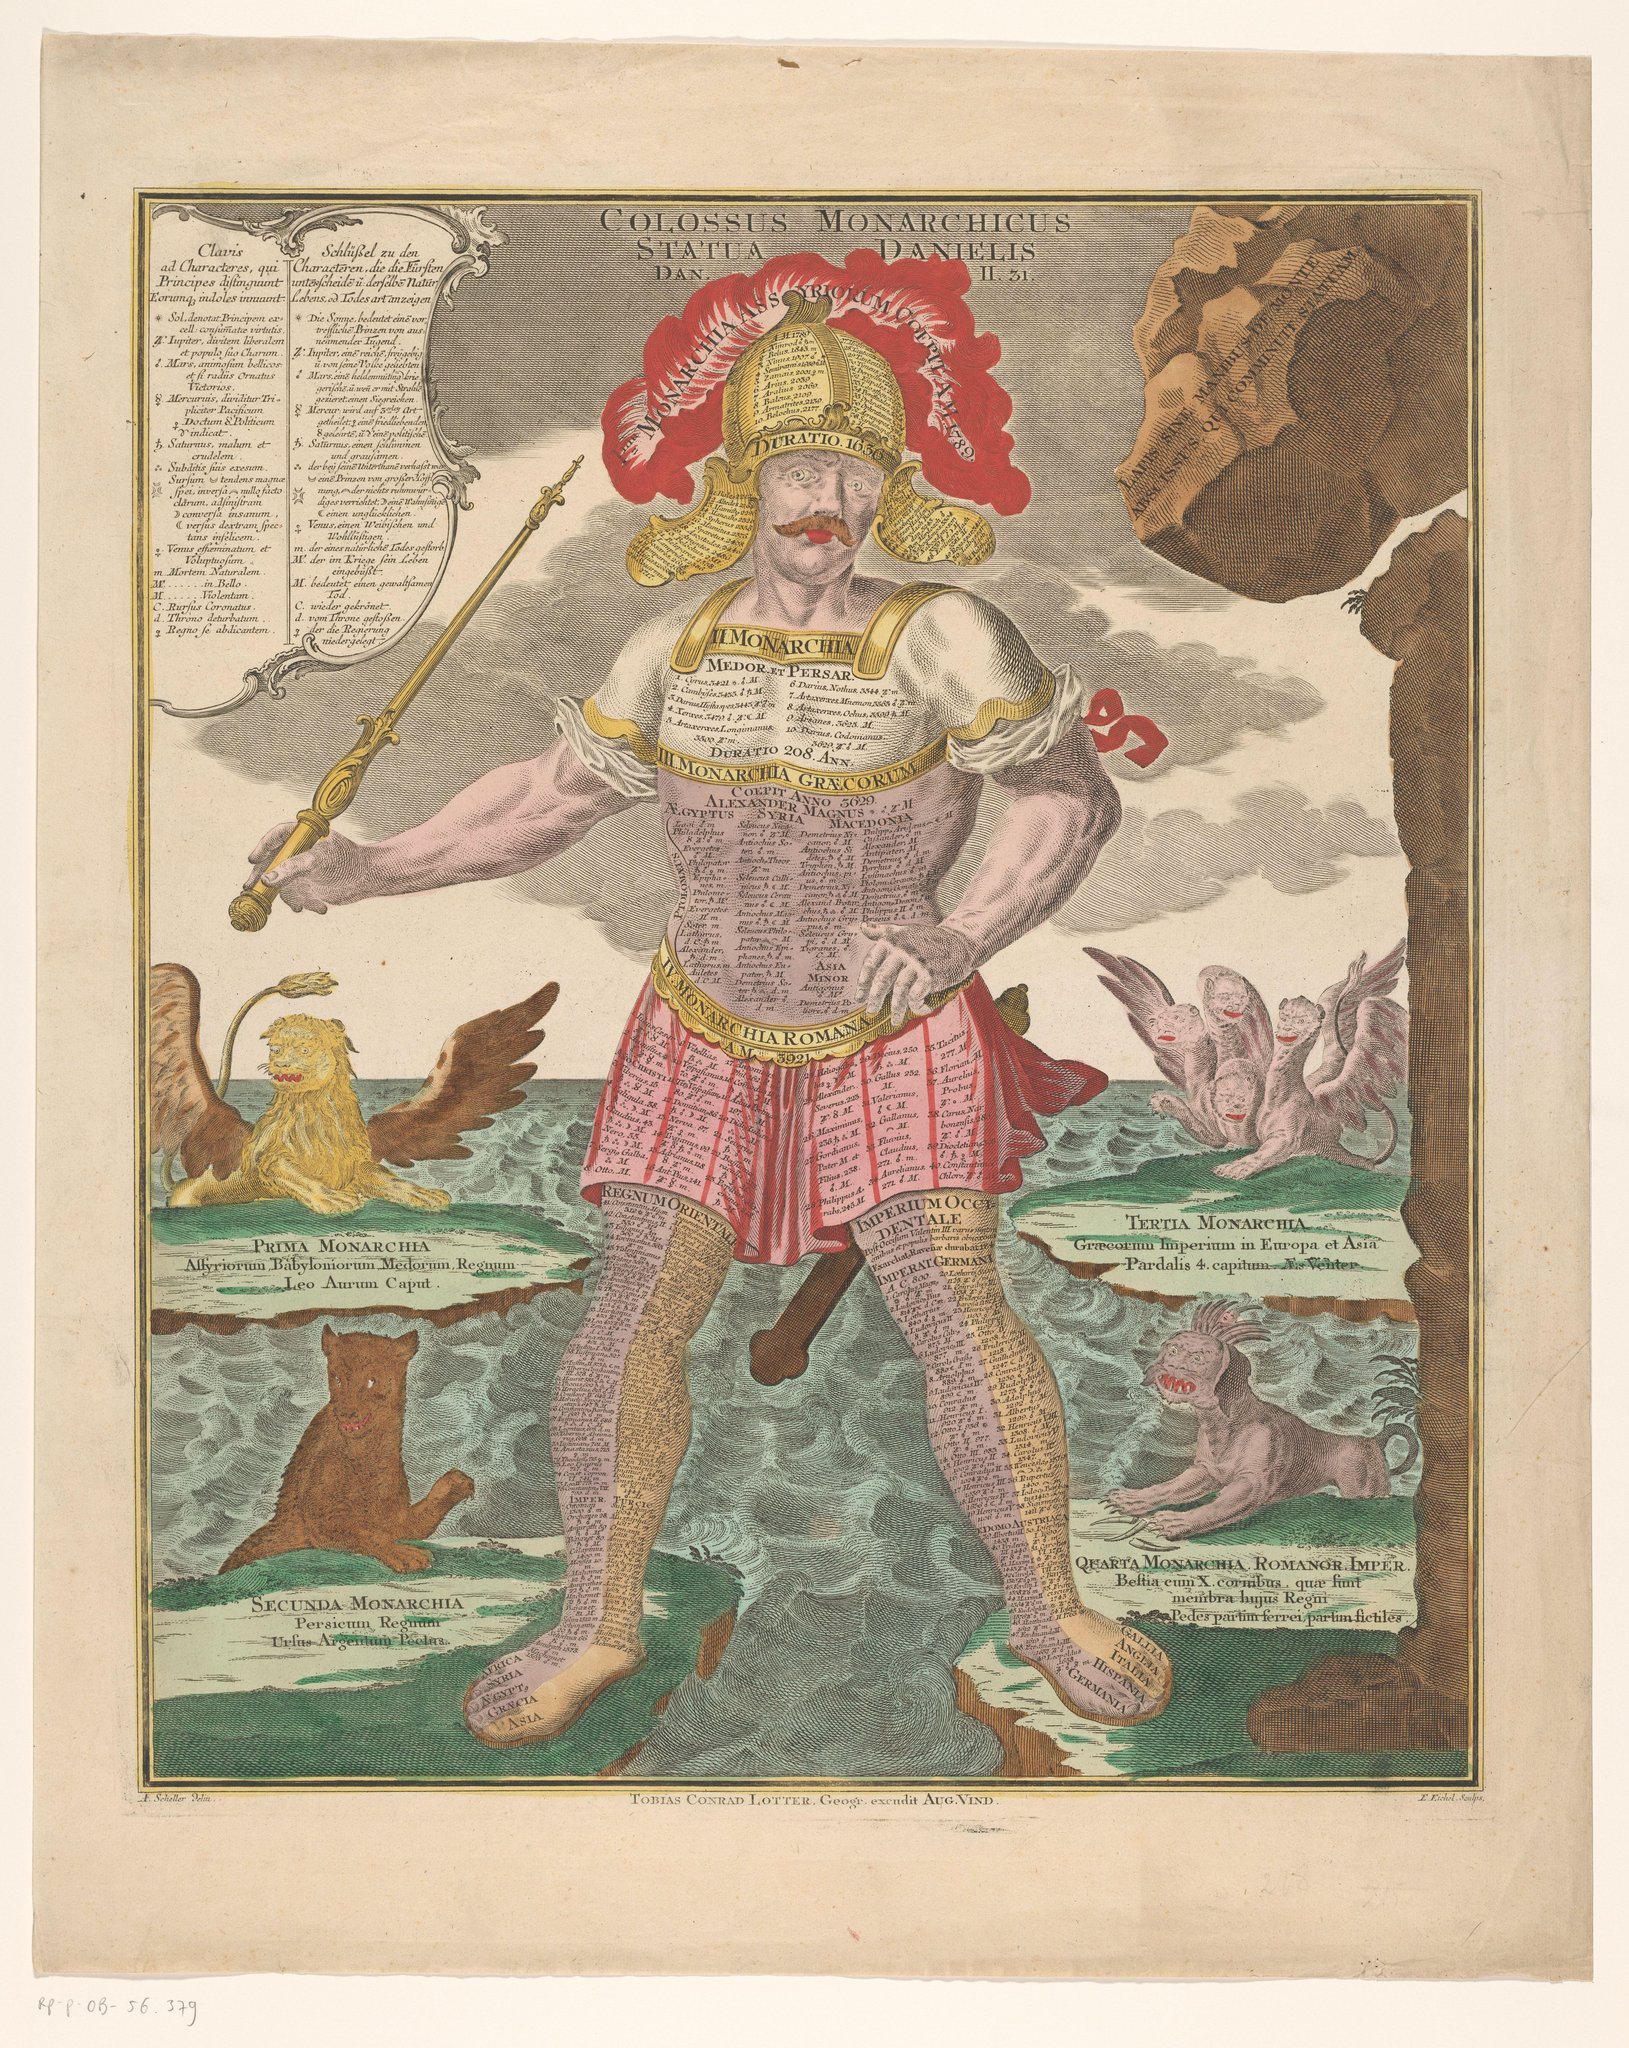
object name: print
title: Colossus Monarchicus Statua Danielis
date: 1727-1782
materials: paper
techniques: etching, hand coloring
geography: augsburg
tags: daniel (not in biblical context); possible attributes: phrygian bonnet, lion(s), ram, chronology, history, mis-shapen animals; monsters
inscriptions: collector's mark: Lugt 2228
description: Op het kolossale standbeeld van Daniël is een tijdlijn geschreven van de monarchieën. Het beeld is gemaakt van verschillende materialen die de tijdperken symboliseren: goud, zilver, brons etc.